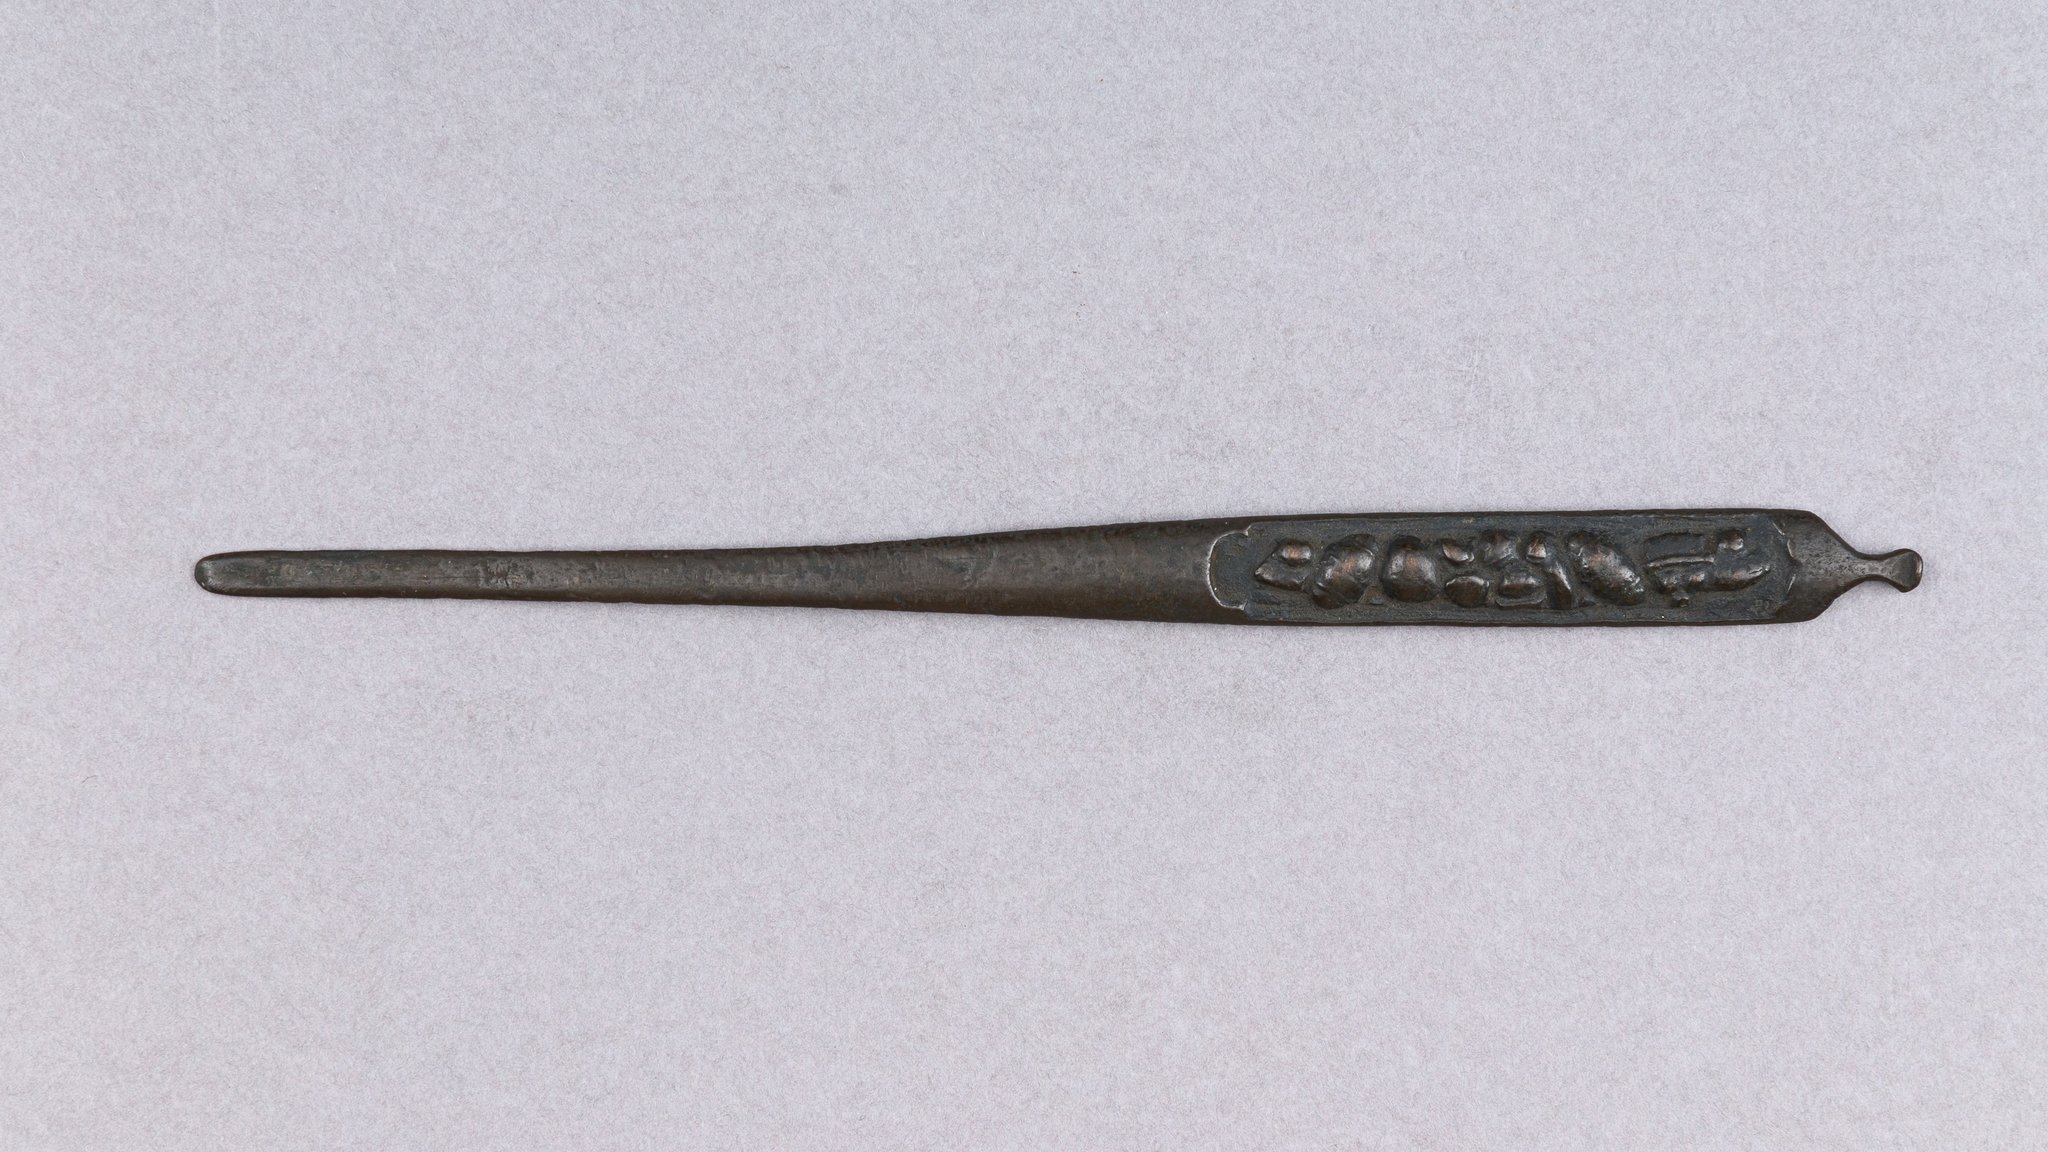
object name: hair dressing tool kogai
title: Hair Dressing Tool (Kogai)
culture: japanese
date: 1401-1500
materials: iron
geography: japan